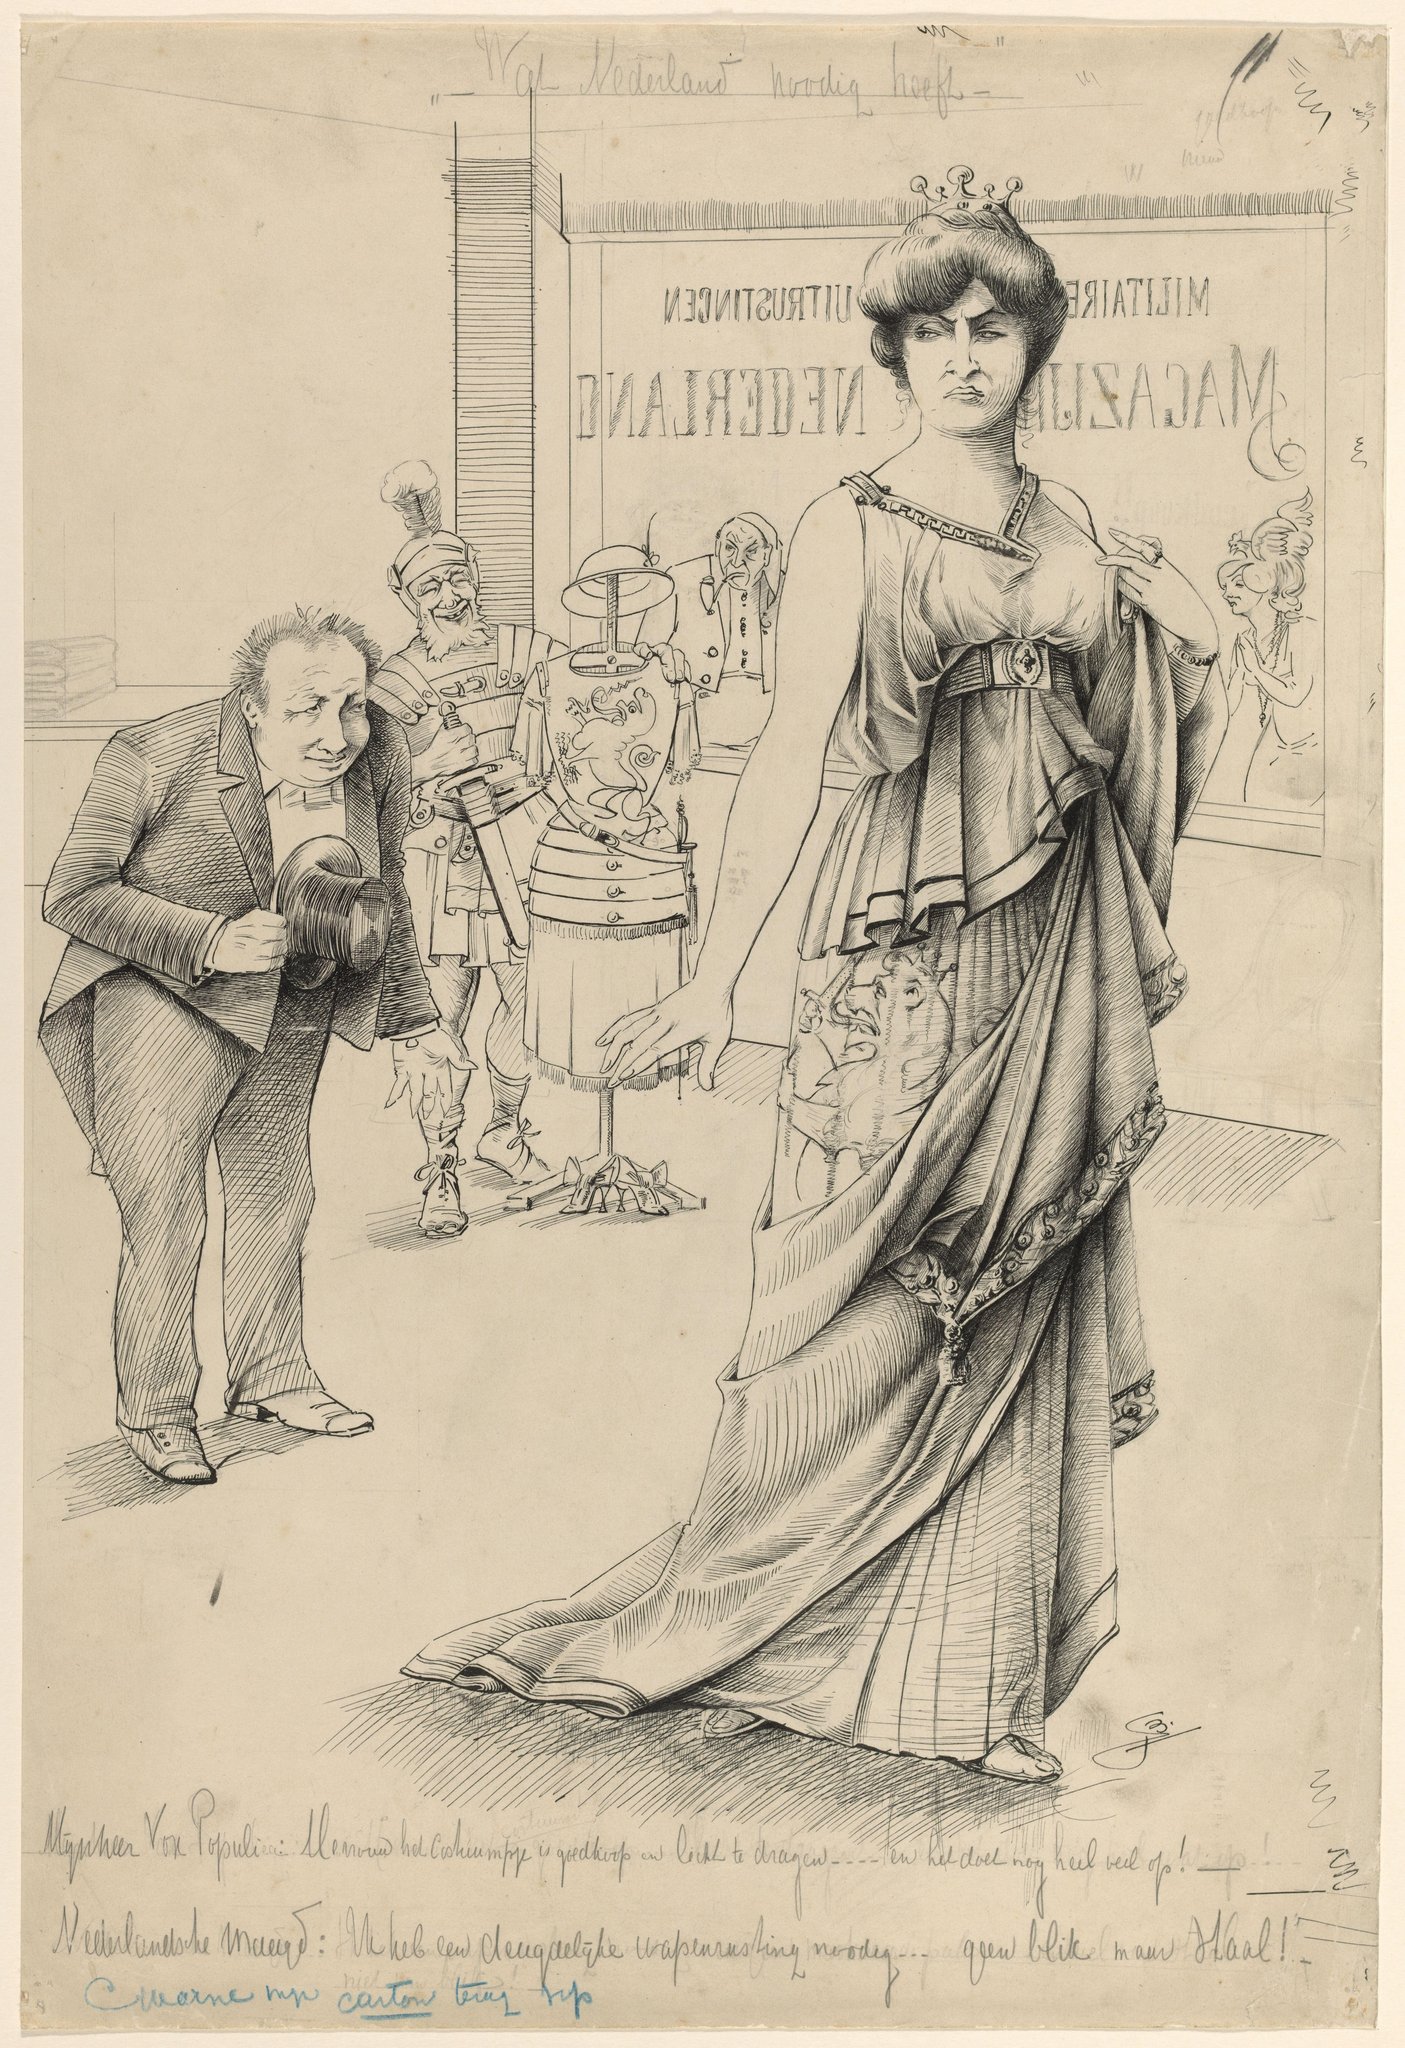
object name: drawing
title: Wat Nederland noodig heeft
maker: Anonymous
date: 1920-1930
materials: paper, pencil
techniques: pen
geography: netherlands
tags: shop, store, personifications of countries, nations, states, districts, etc., (military) uniforms, tailor, dressmaker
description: Ontwerptekening voor een politieke spotprent, ca. 1920-1930. De Nederlandse Maagd in een winkel waar haar nieuwe potsierlijke militaire uitrusting wordt getoond. Zij keurt deze met een afwijzend gebaar af en met de woorden 'Ik heb een deugdelijke wapenrusting noodig ... geen blik maar staal!'. Met meerdere opschriften in potlood.